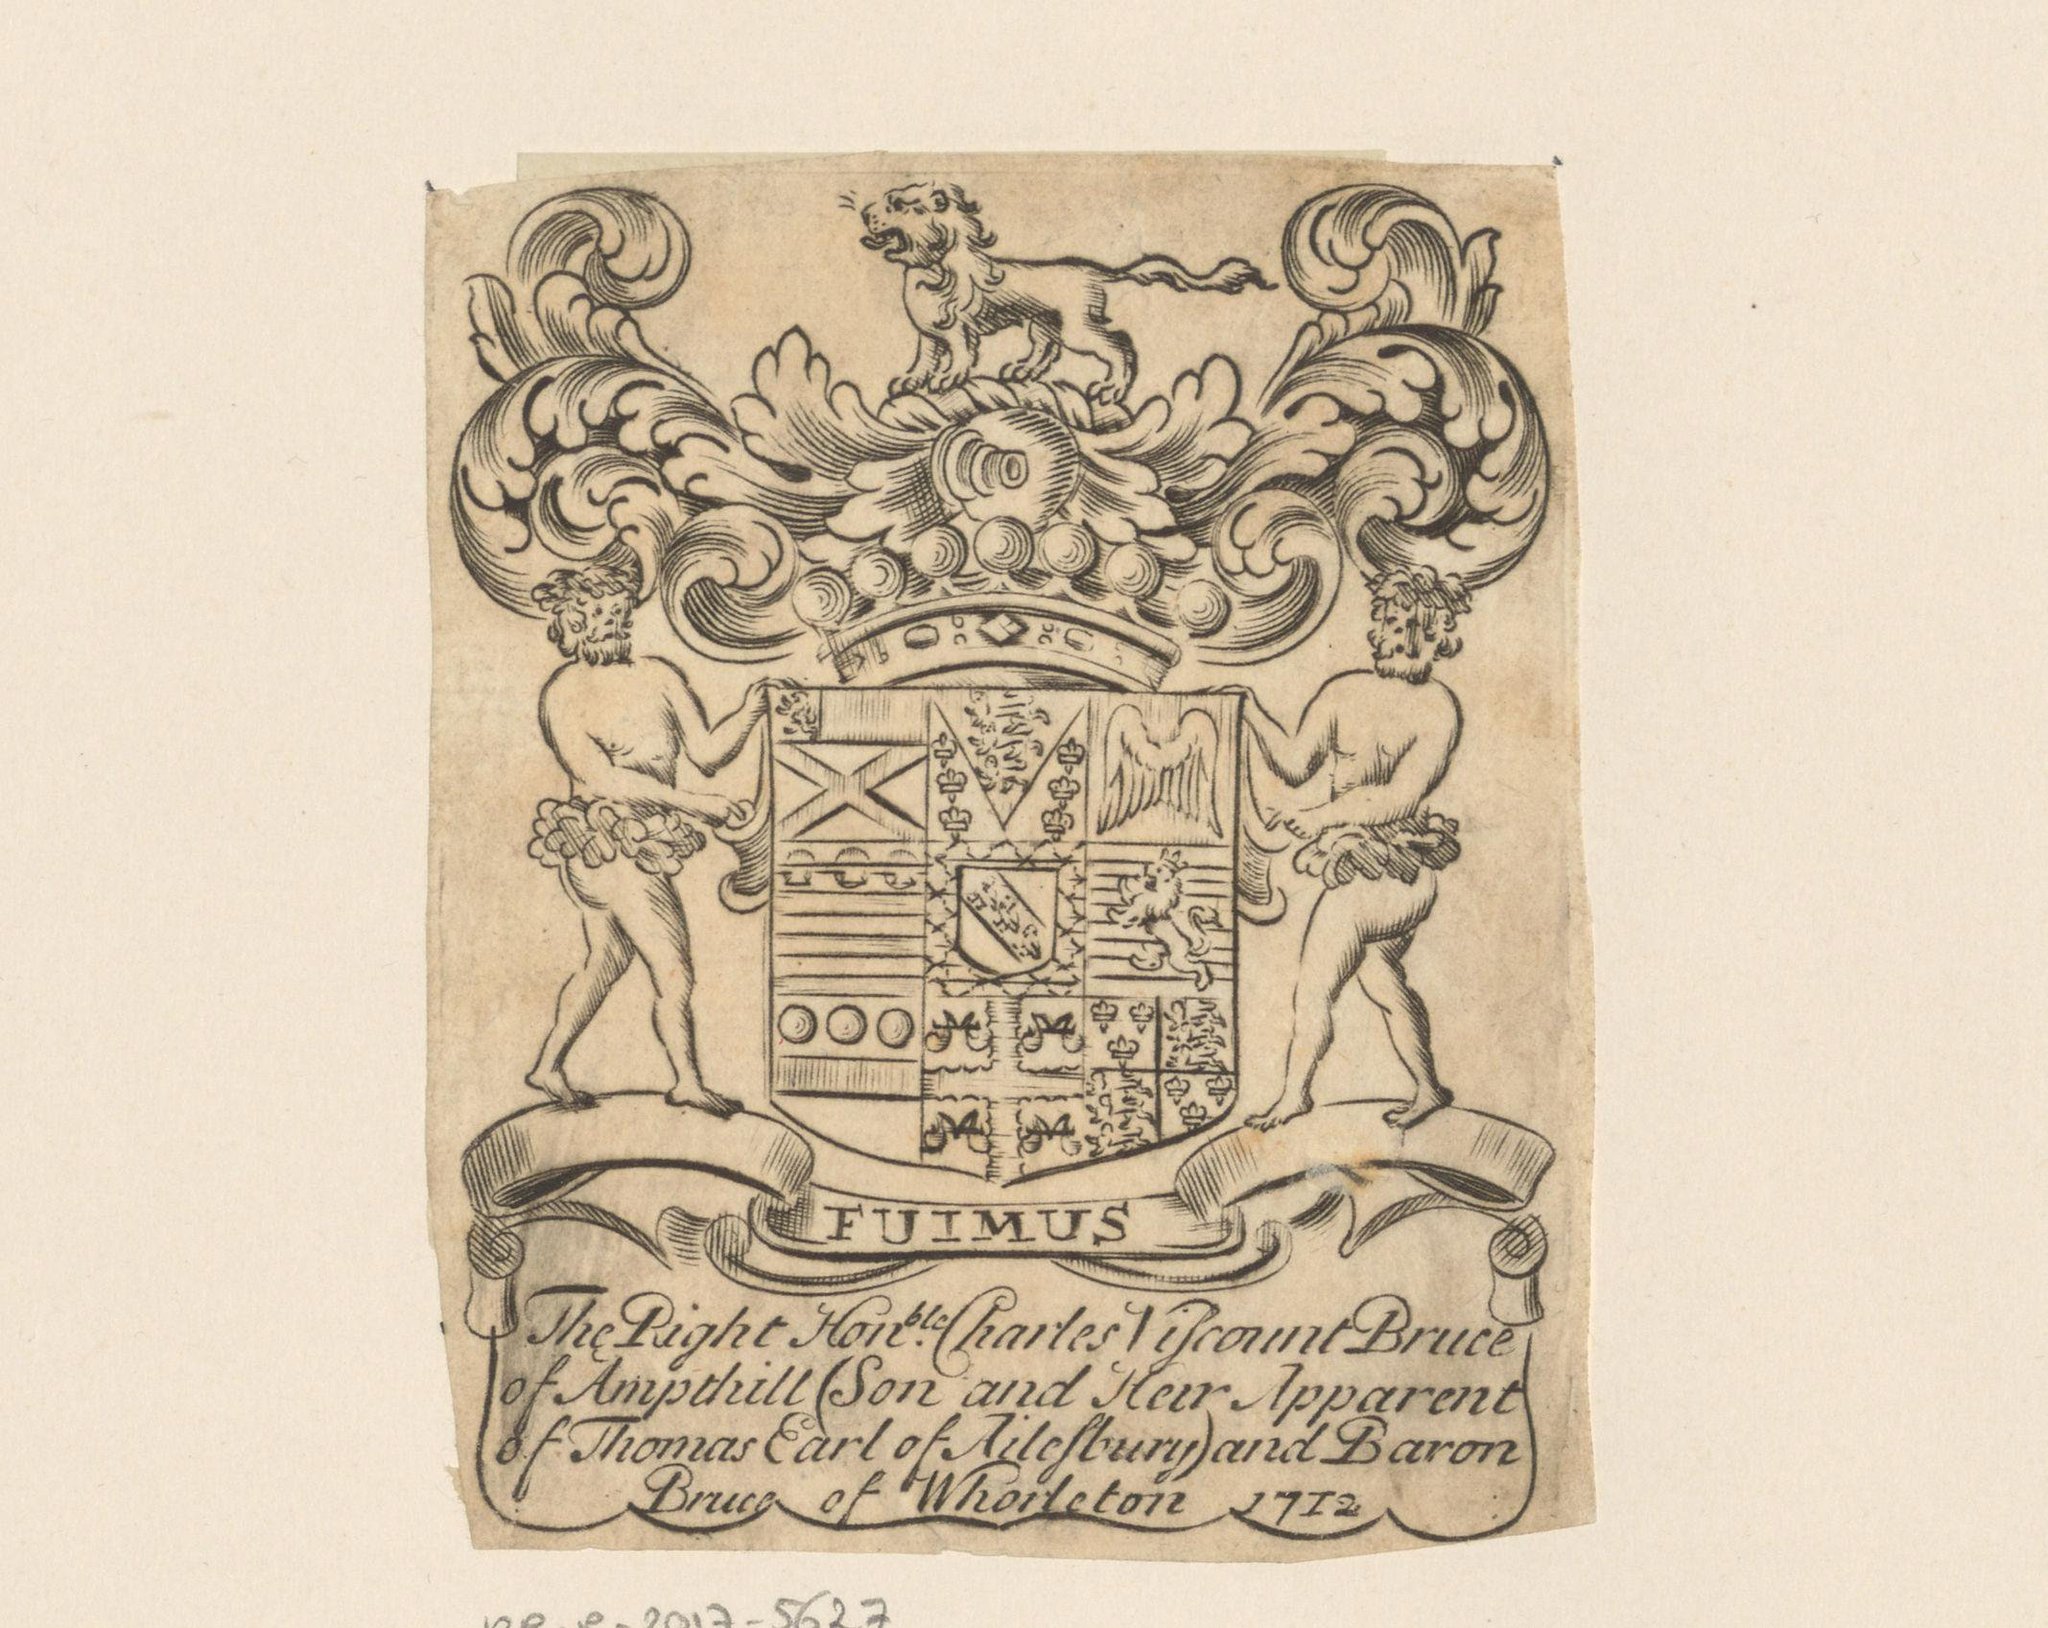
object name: bookplate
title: Ex libris van Charles viscount Bruce of Ampthill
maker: Anonymous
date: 1712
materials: paper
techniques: etching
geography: england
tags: politician, armorial bearing, heraldry, man (showing himself) undressed, quasi-nude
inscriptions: date